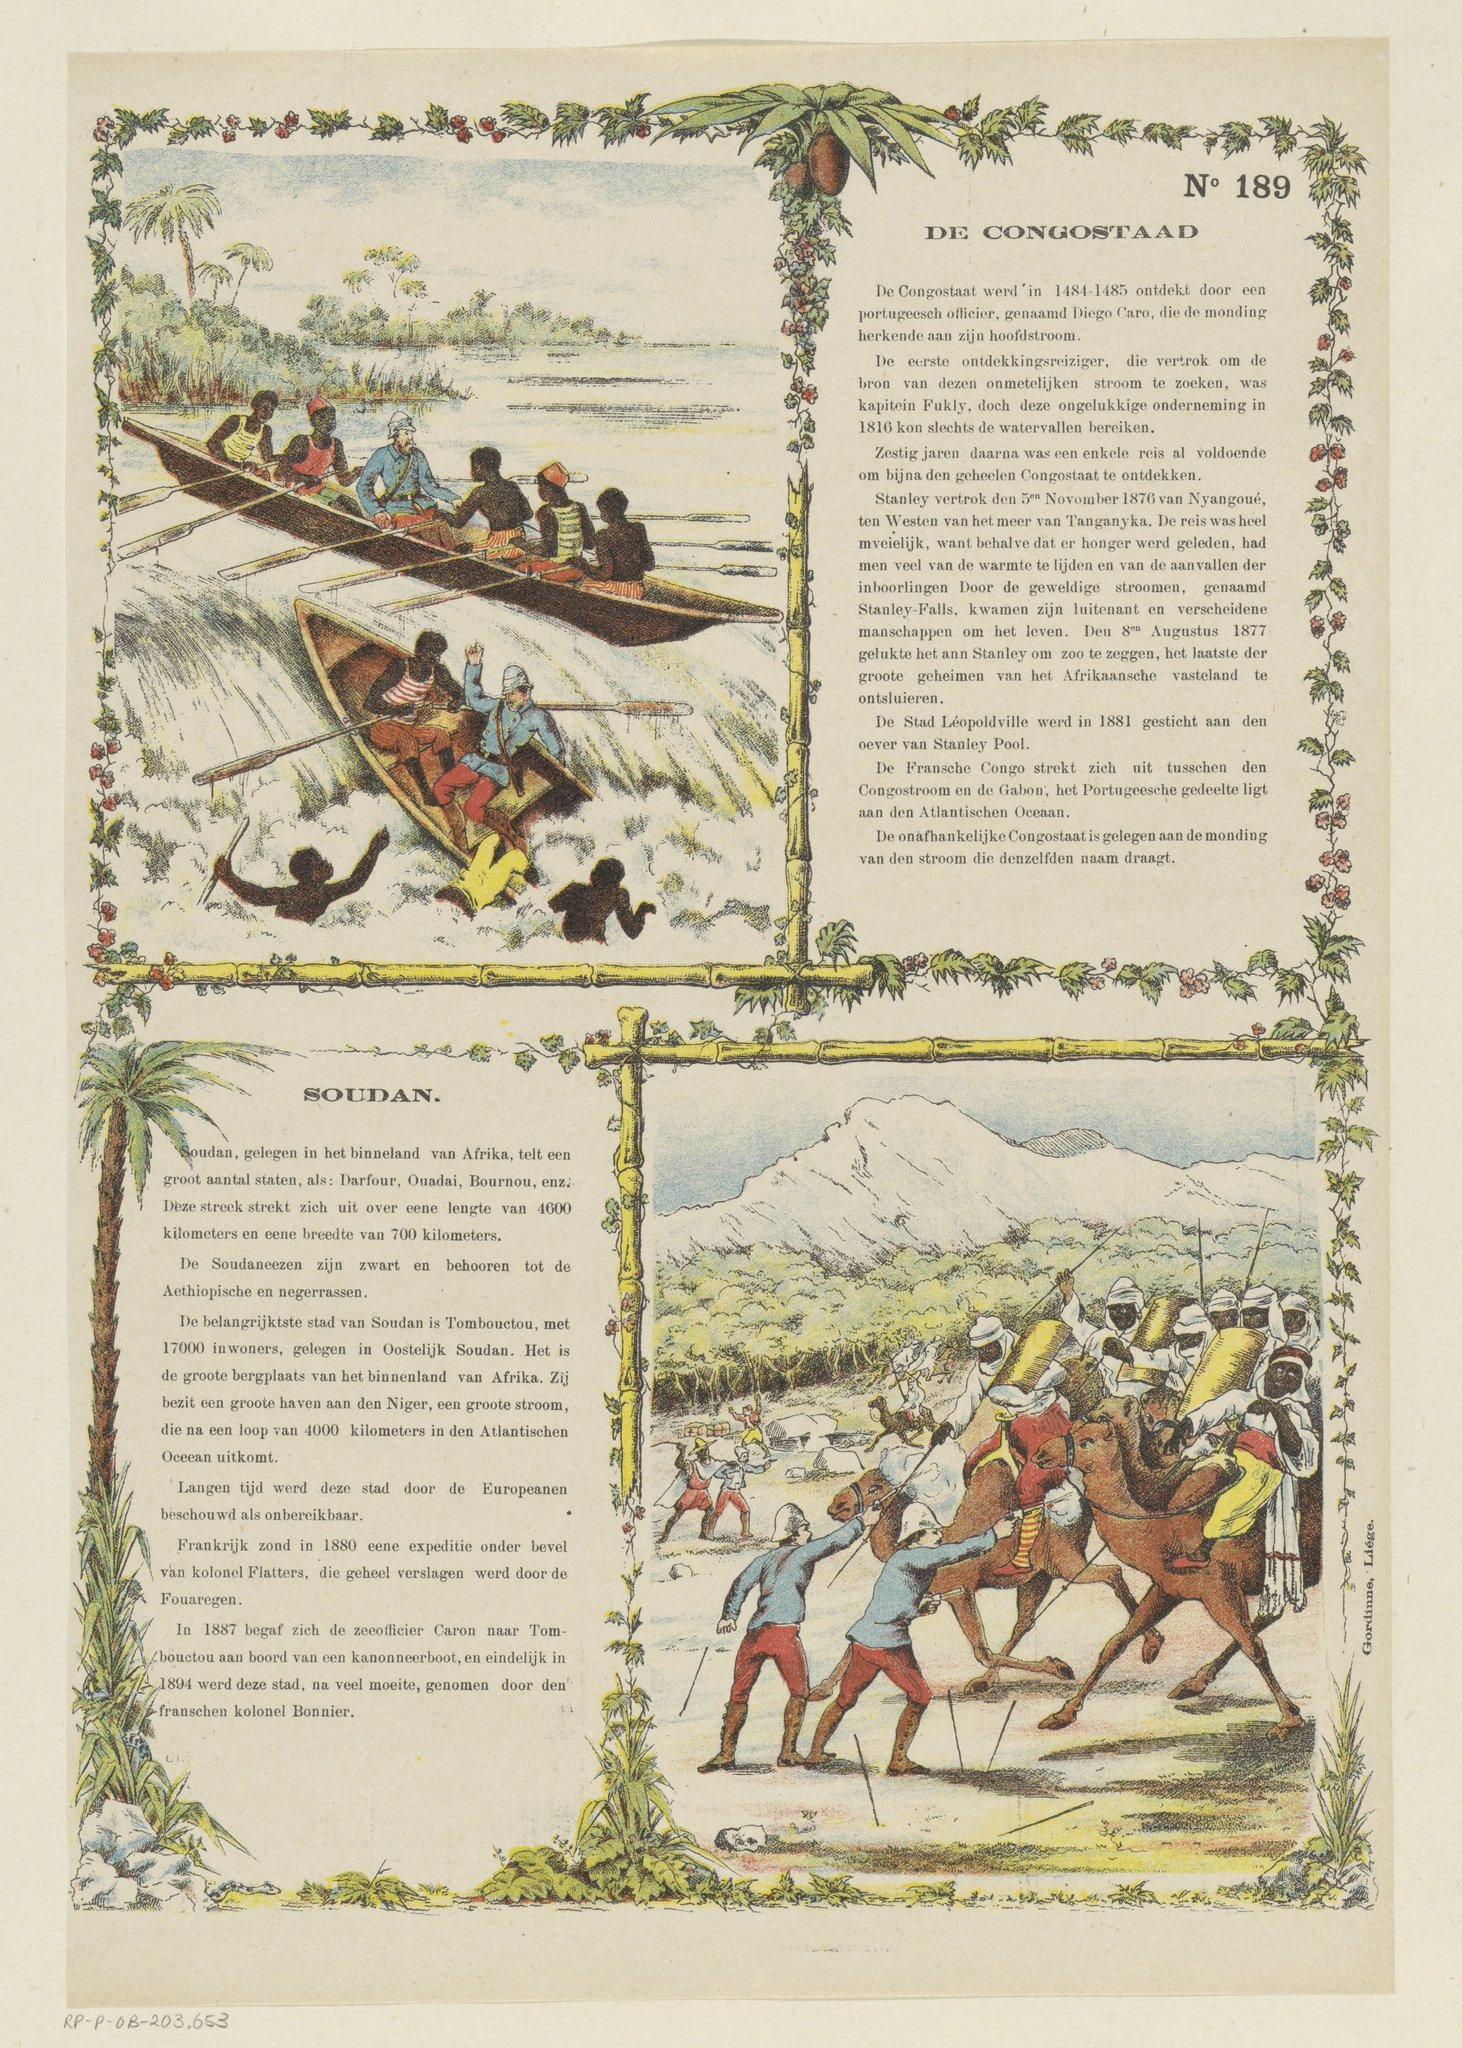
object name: popular print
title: De Congostaad / Soudan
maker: a. de ker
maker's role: print maker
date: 1894-1959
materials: paper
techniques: lithograph, letterpress printing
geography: liège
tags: london, africans, the soldier; the soldier's life, exploration, expedition, voyage of discovery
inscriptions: collector's mark: Lugt 2760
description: Blad met twee voorstellingen. Linksboven een voorstelling van de ontdekkingsreiziger Henry Stanley met Afrikaanse mannen in roeiboten op de Boyomawatervallen (voorheen de Stanleywatervallen) te Congo. Rechtsonder een voorstelling van Europese soldaten in gevecht met strijders te paard uit de Sahel (voorheen Soedan). Rechtsboven en linksonder vakken met bijschriften. Het geheel wordt omgeven door een sierrand. Genummerd rechtsboven: No 189.